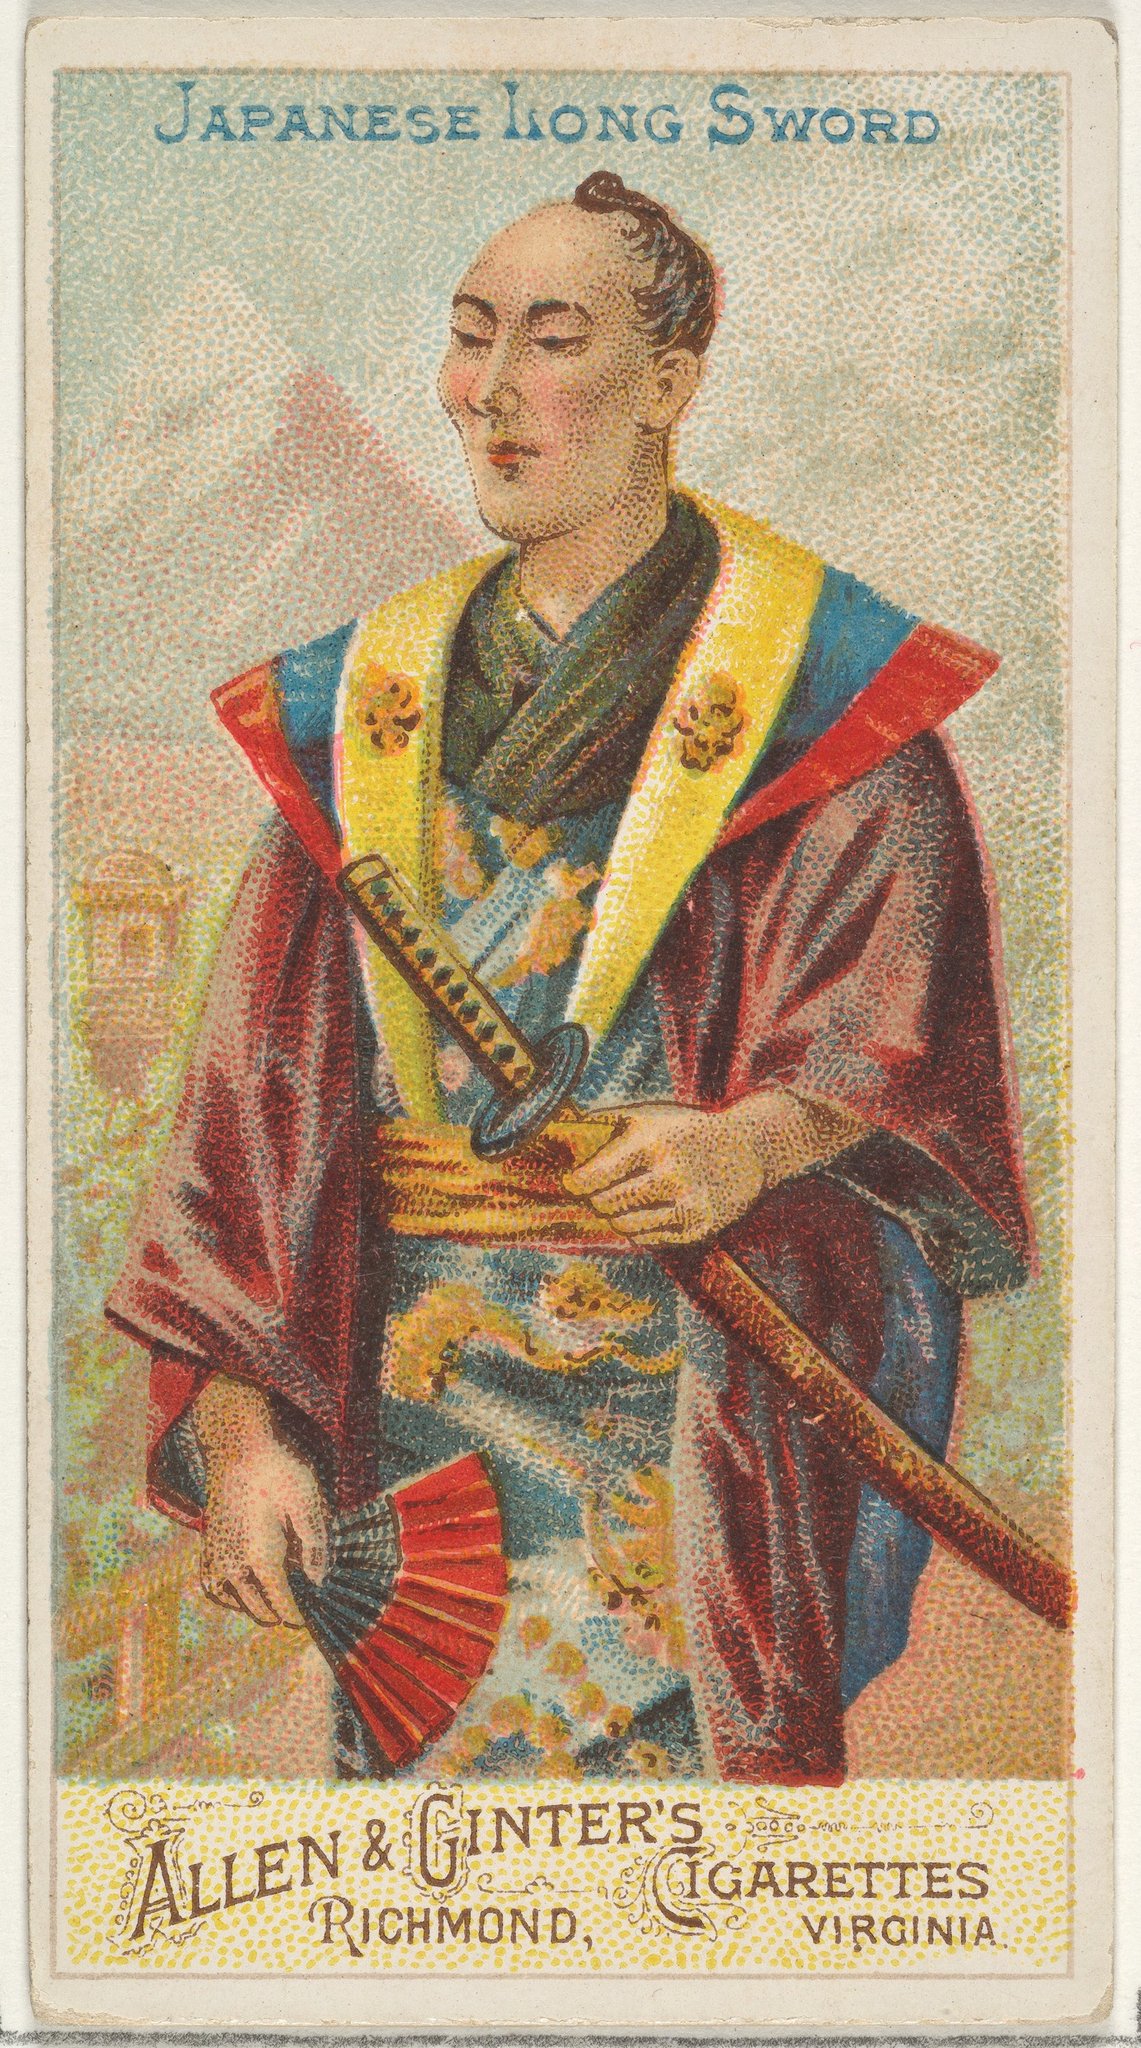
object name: print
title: Japanese Long Sword, from the Arms of All Nations series (N3) for Allen & Ginter Cigarettes Brands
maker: allen & ginter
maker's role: publisher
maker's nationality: american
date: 1887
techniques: color lithograph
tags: swords,men